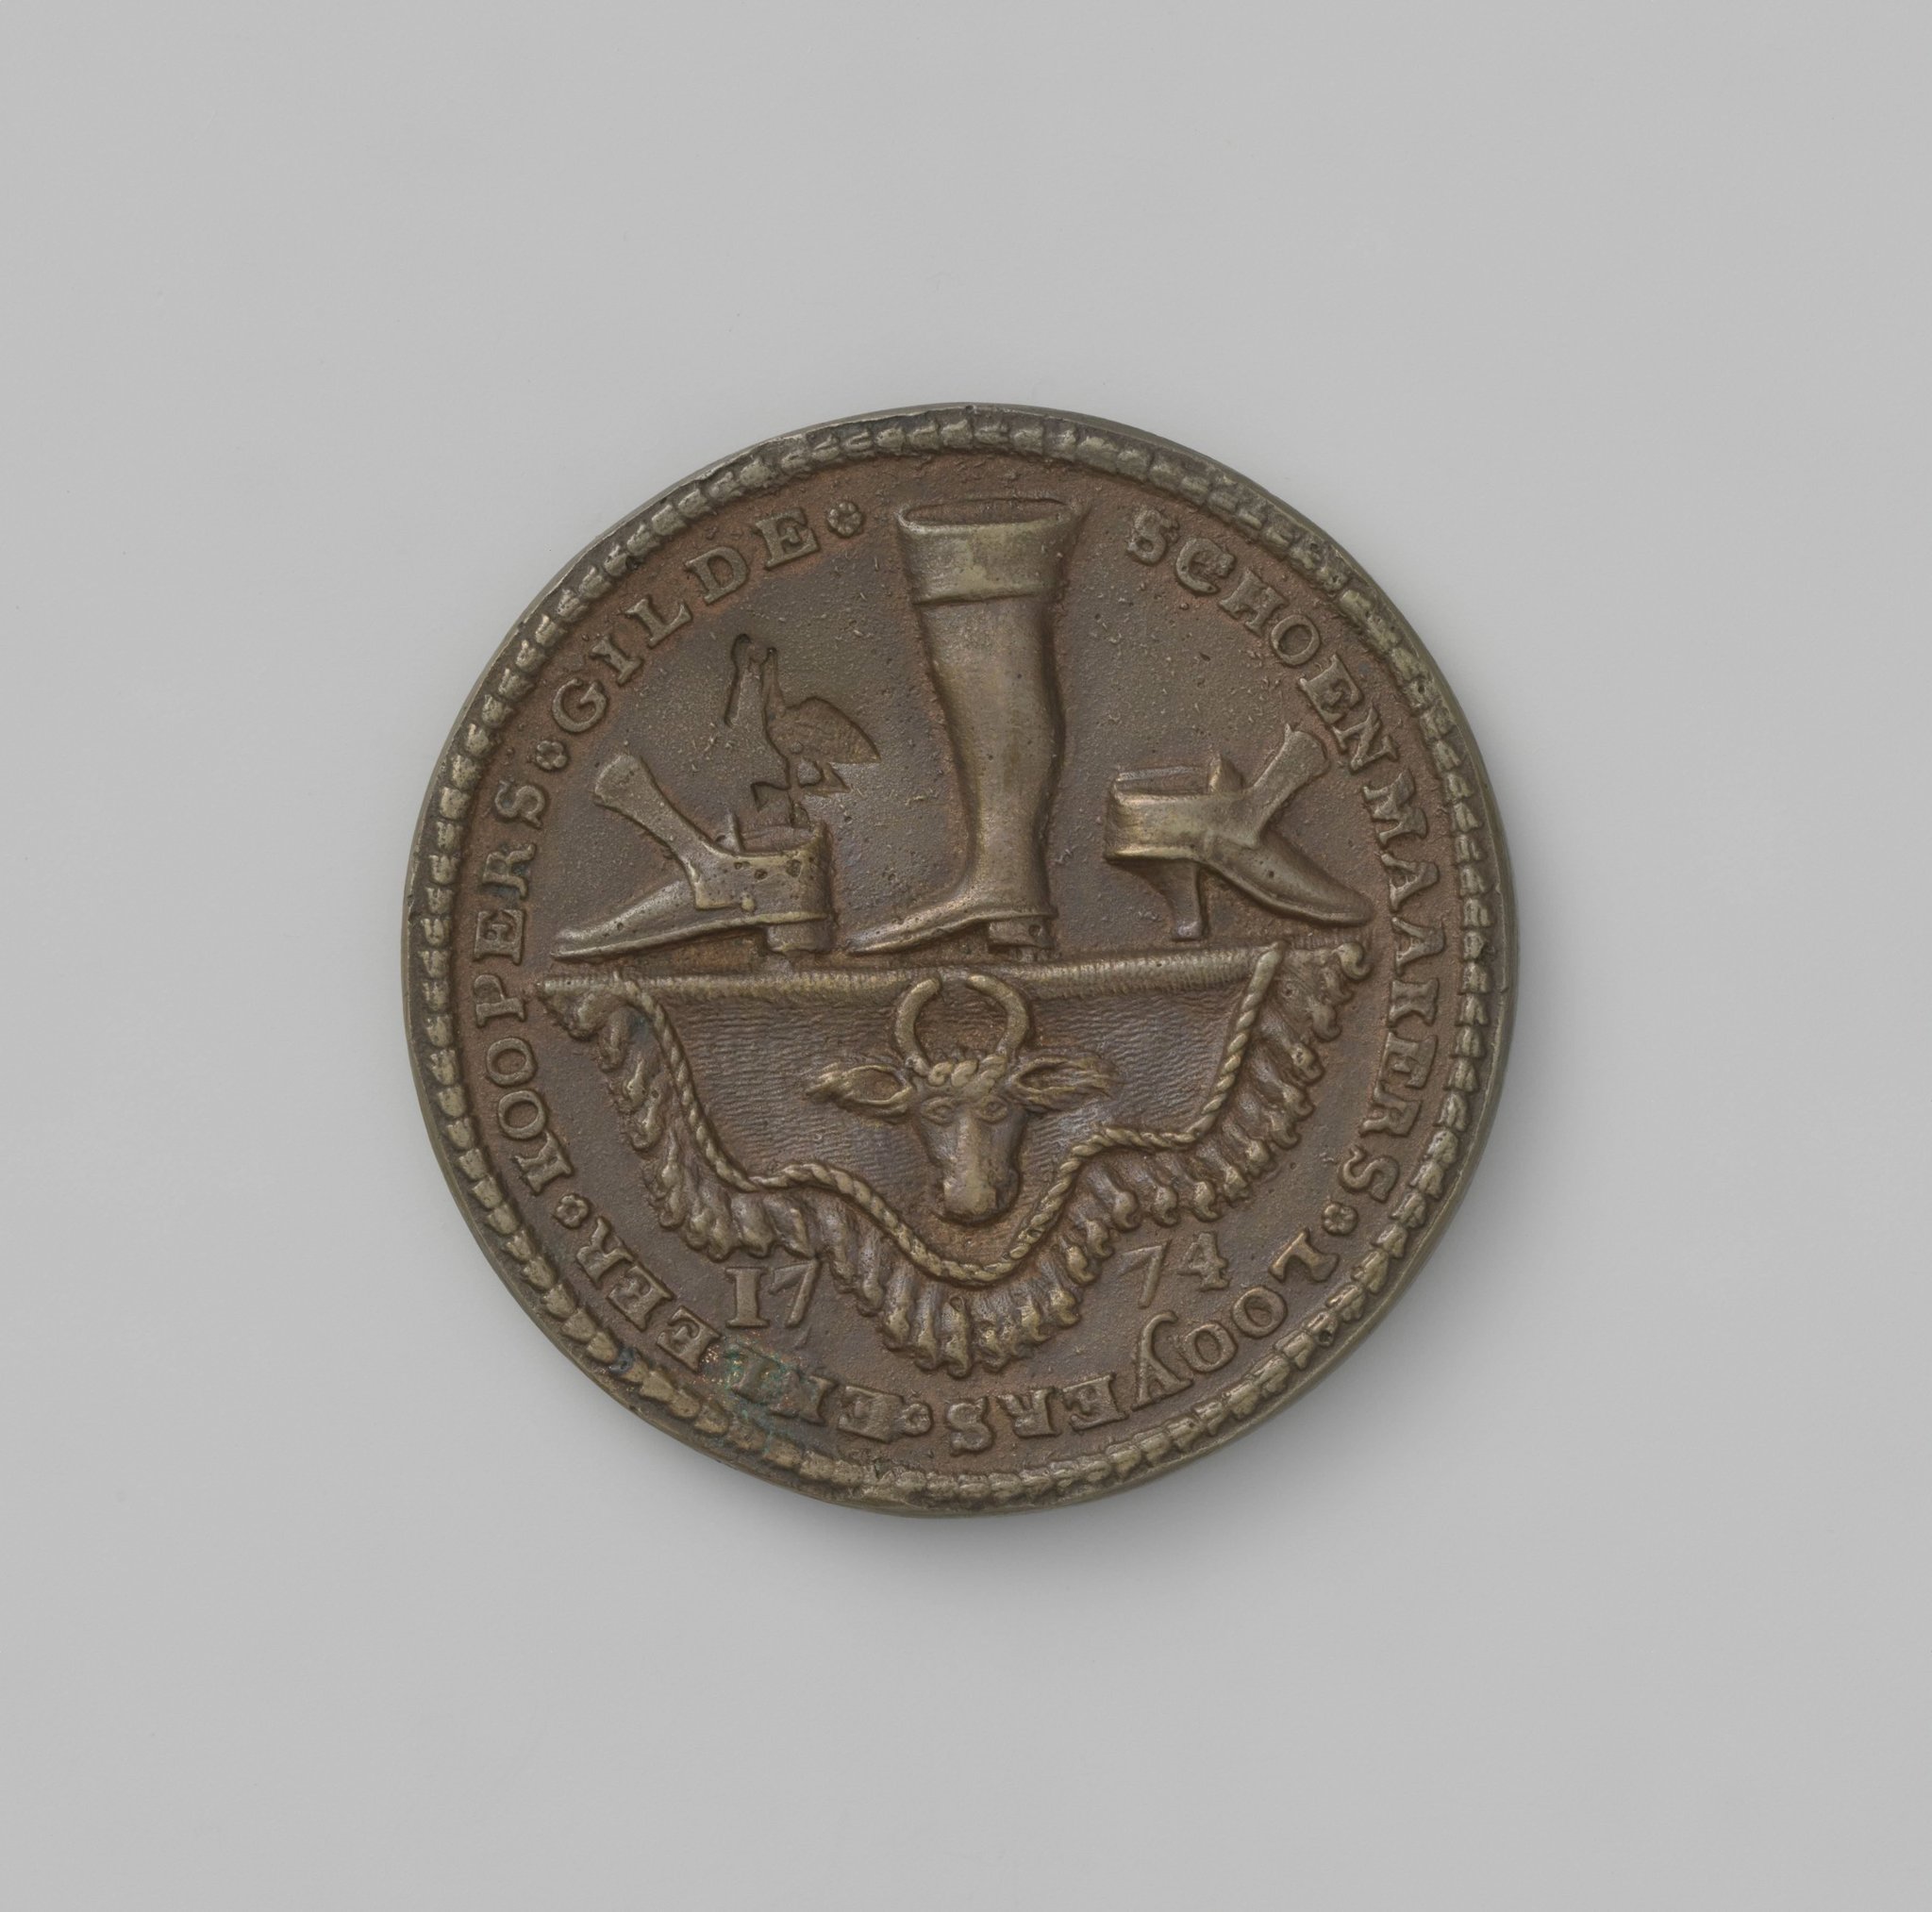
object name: medal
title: The Hague, Shoemakers’ Guild, with Number 109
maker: Anonymous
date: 1774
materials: brass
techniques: printing, casting, engraving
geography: the hague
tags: the hague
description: messing, 1774